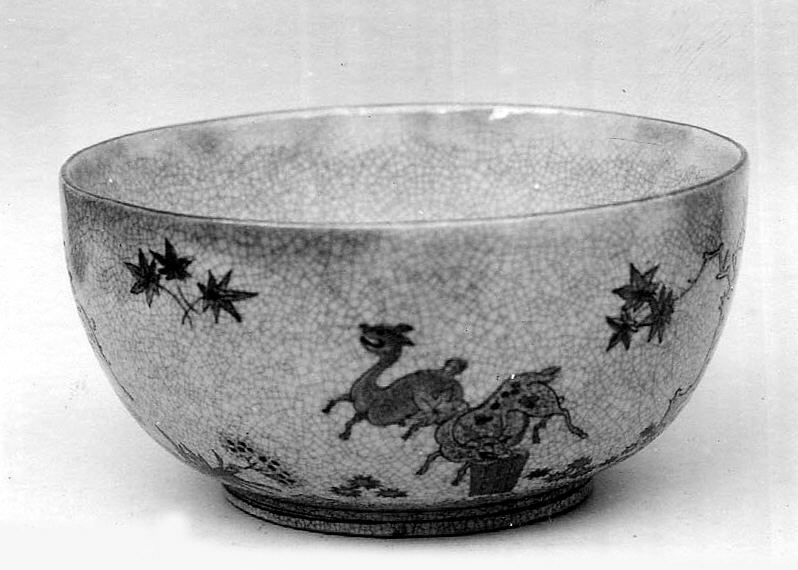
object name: bowl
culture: japanese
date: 1701-1900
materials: enamel, faience, glaze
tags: leaves